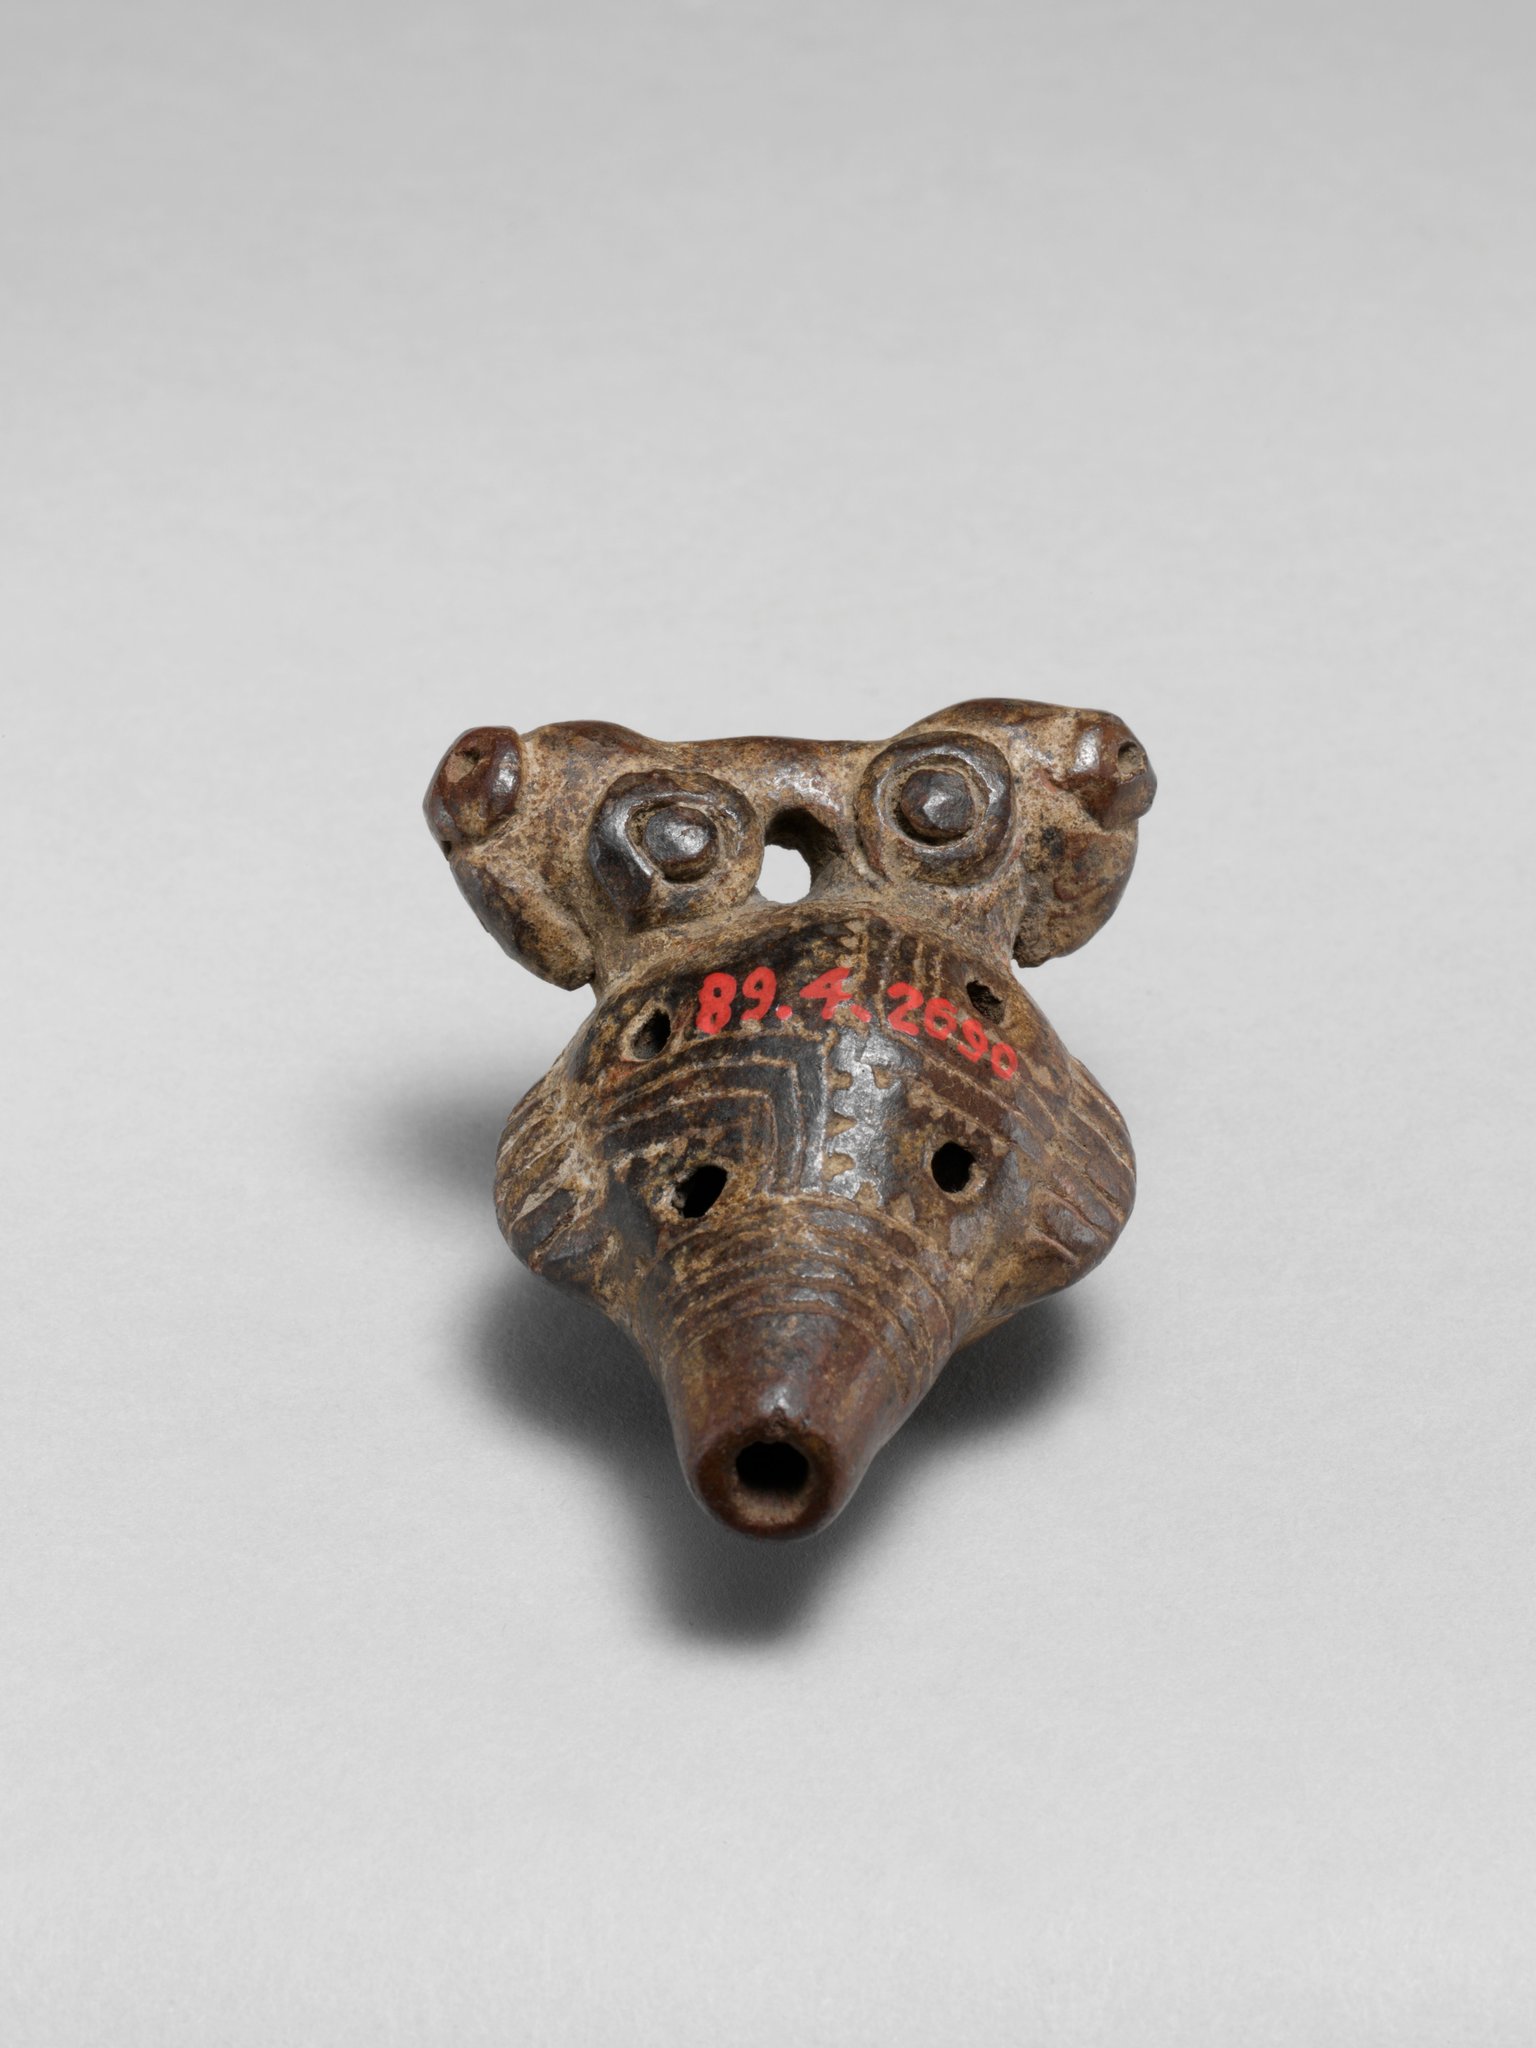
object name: pottery whistle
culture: costa rican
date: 800-1500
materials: clay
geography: costa rica